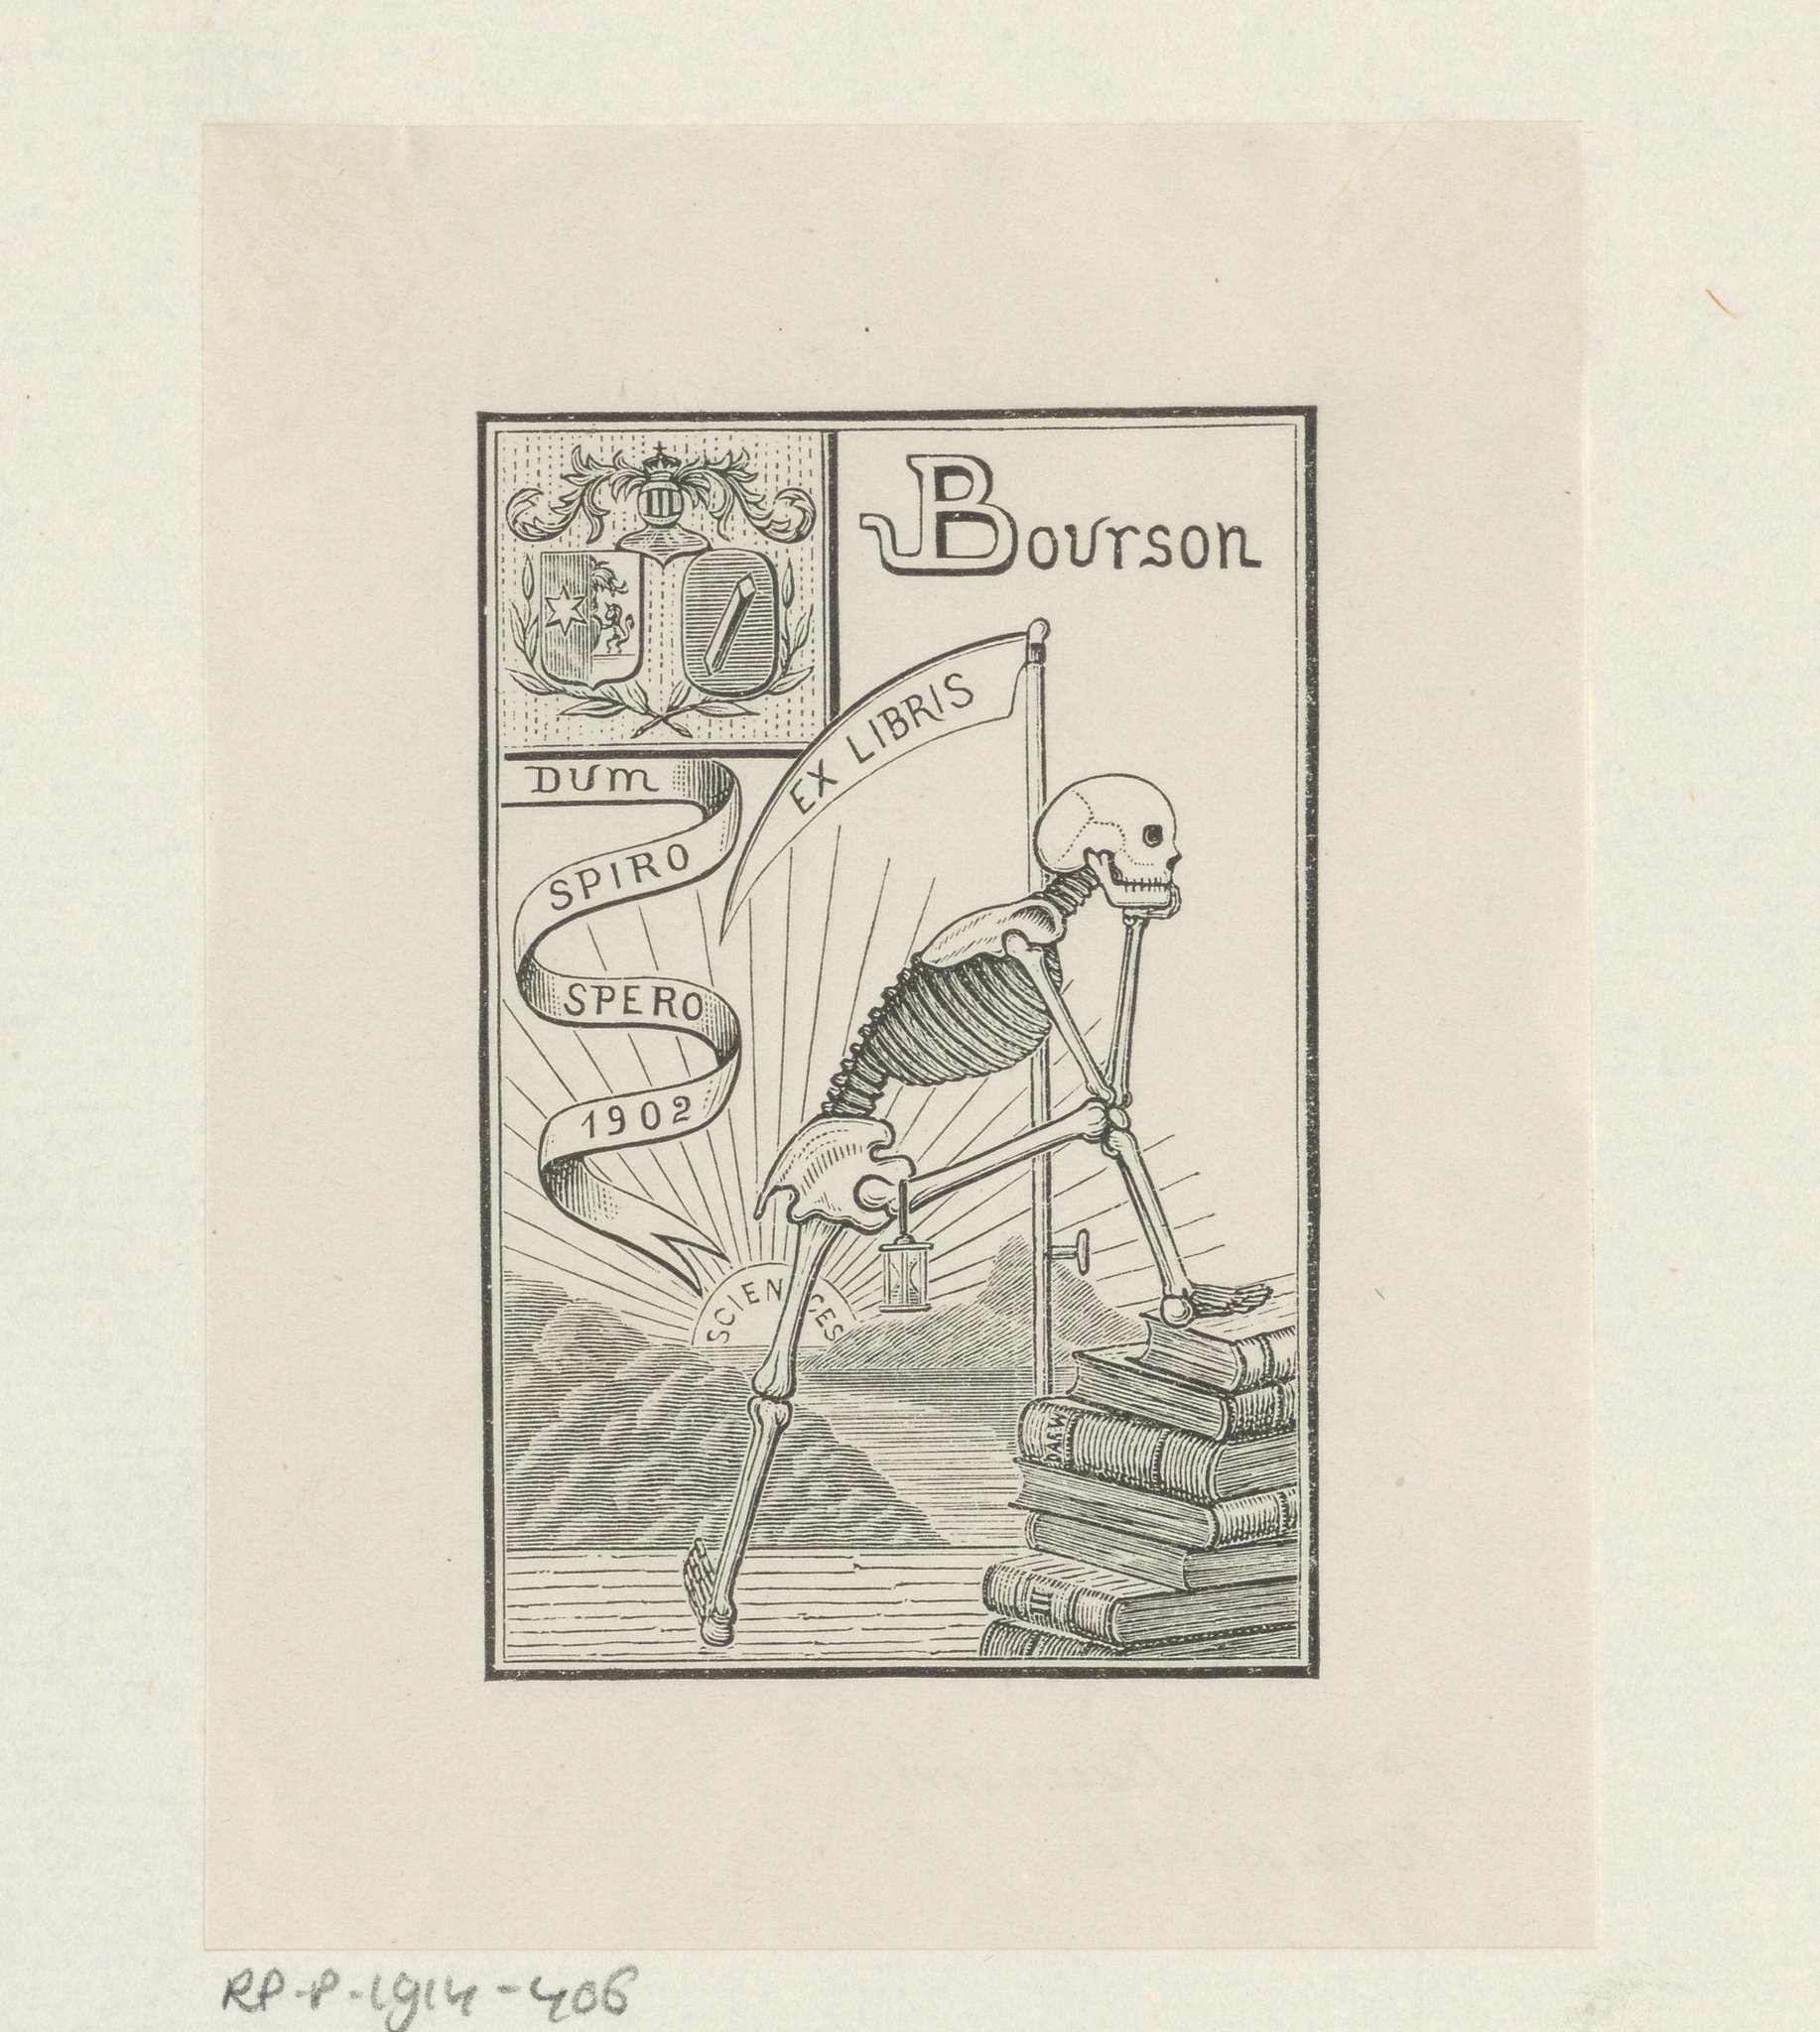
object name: bookplate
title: Ex libris Bourson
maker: Anonymous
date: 1880-1914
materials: paper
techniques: engraving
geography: france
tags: education, science and learning, death as skeleton, book, armorial bearing, heraldry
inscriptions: collector's mark: Lugt 2233, collector's mark: Lugt 2760